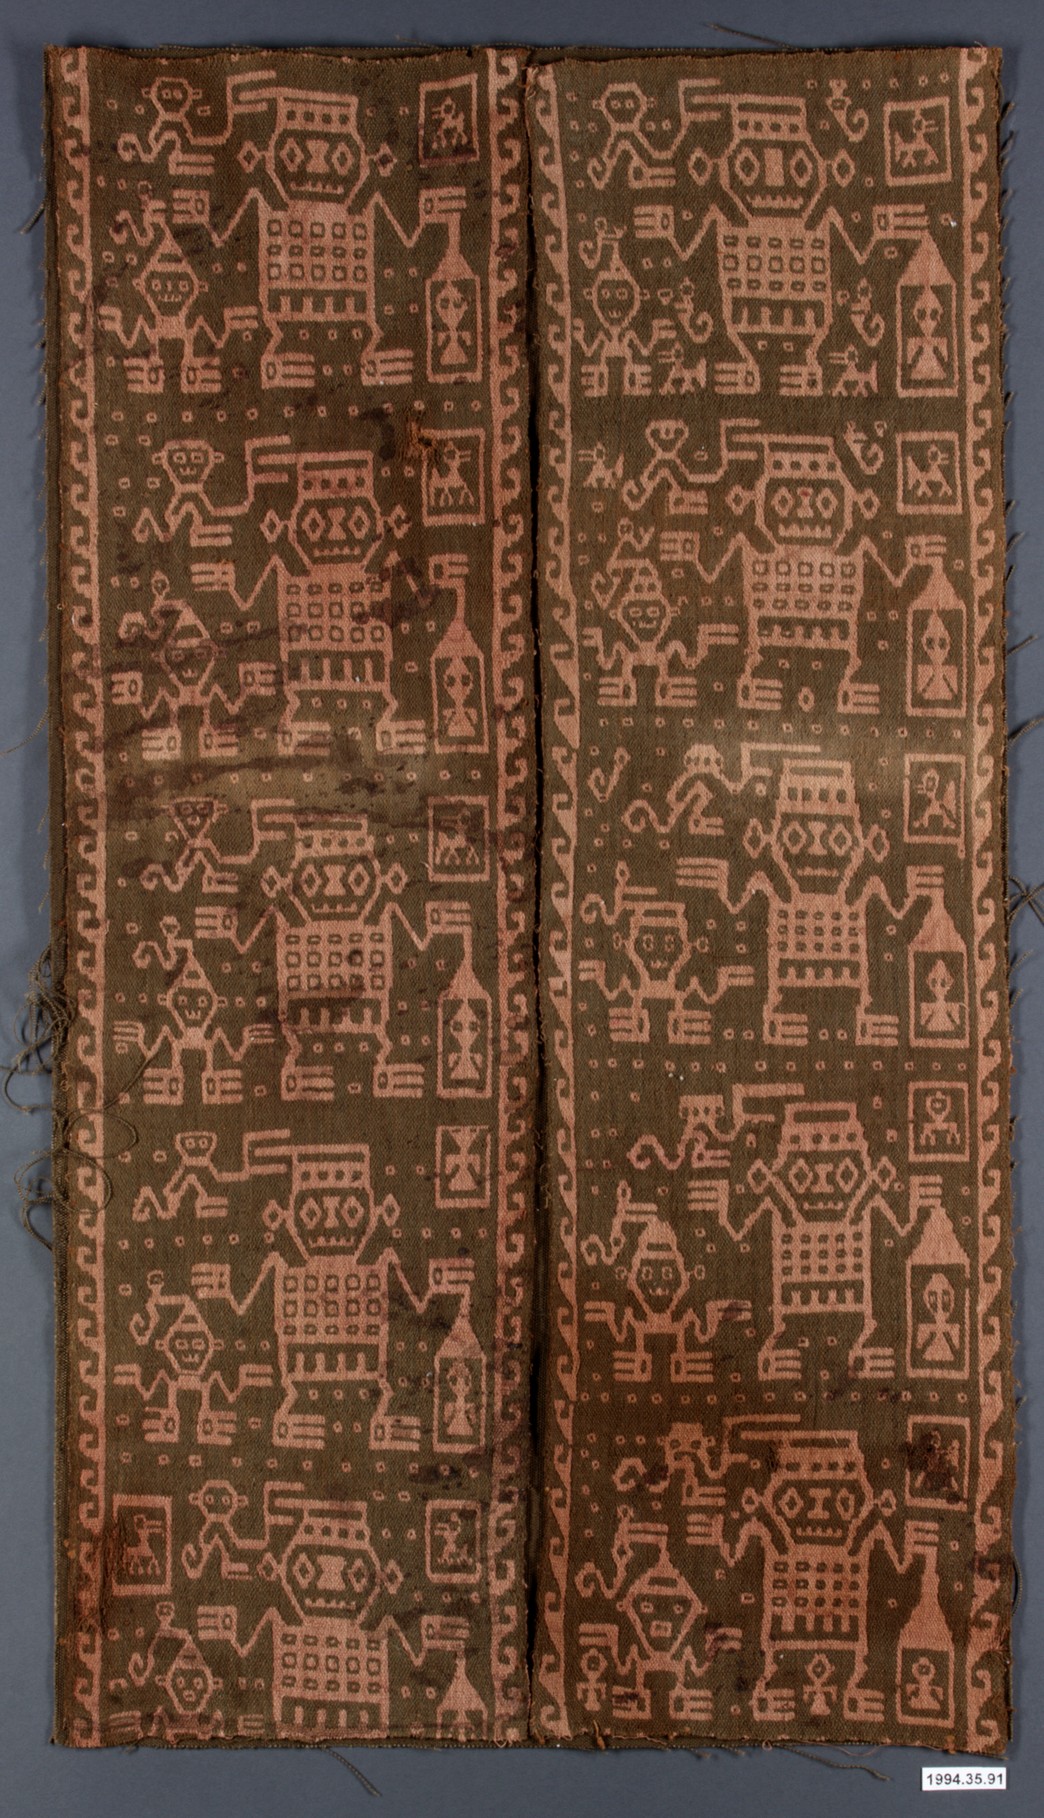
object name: sash fragment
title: Sash Fragments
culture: peruvian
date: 1301-1533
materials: cotton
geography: peru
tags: human figures